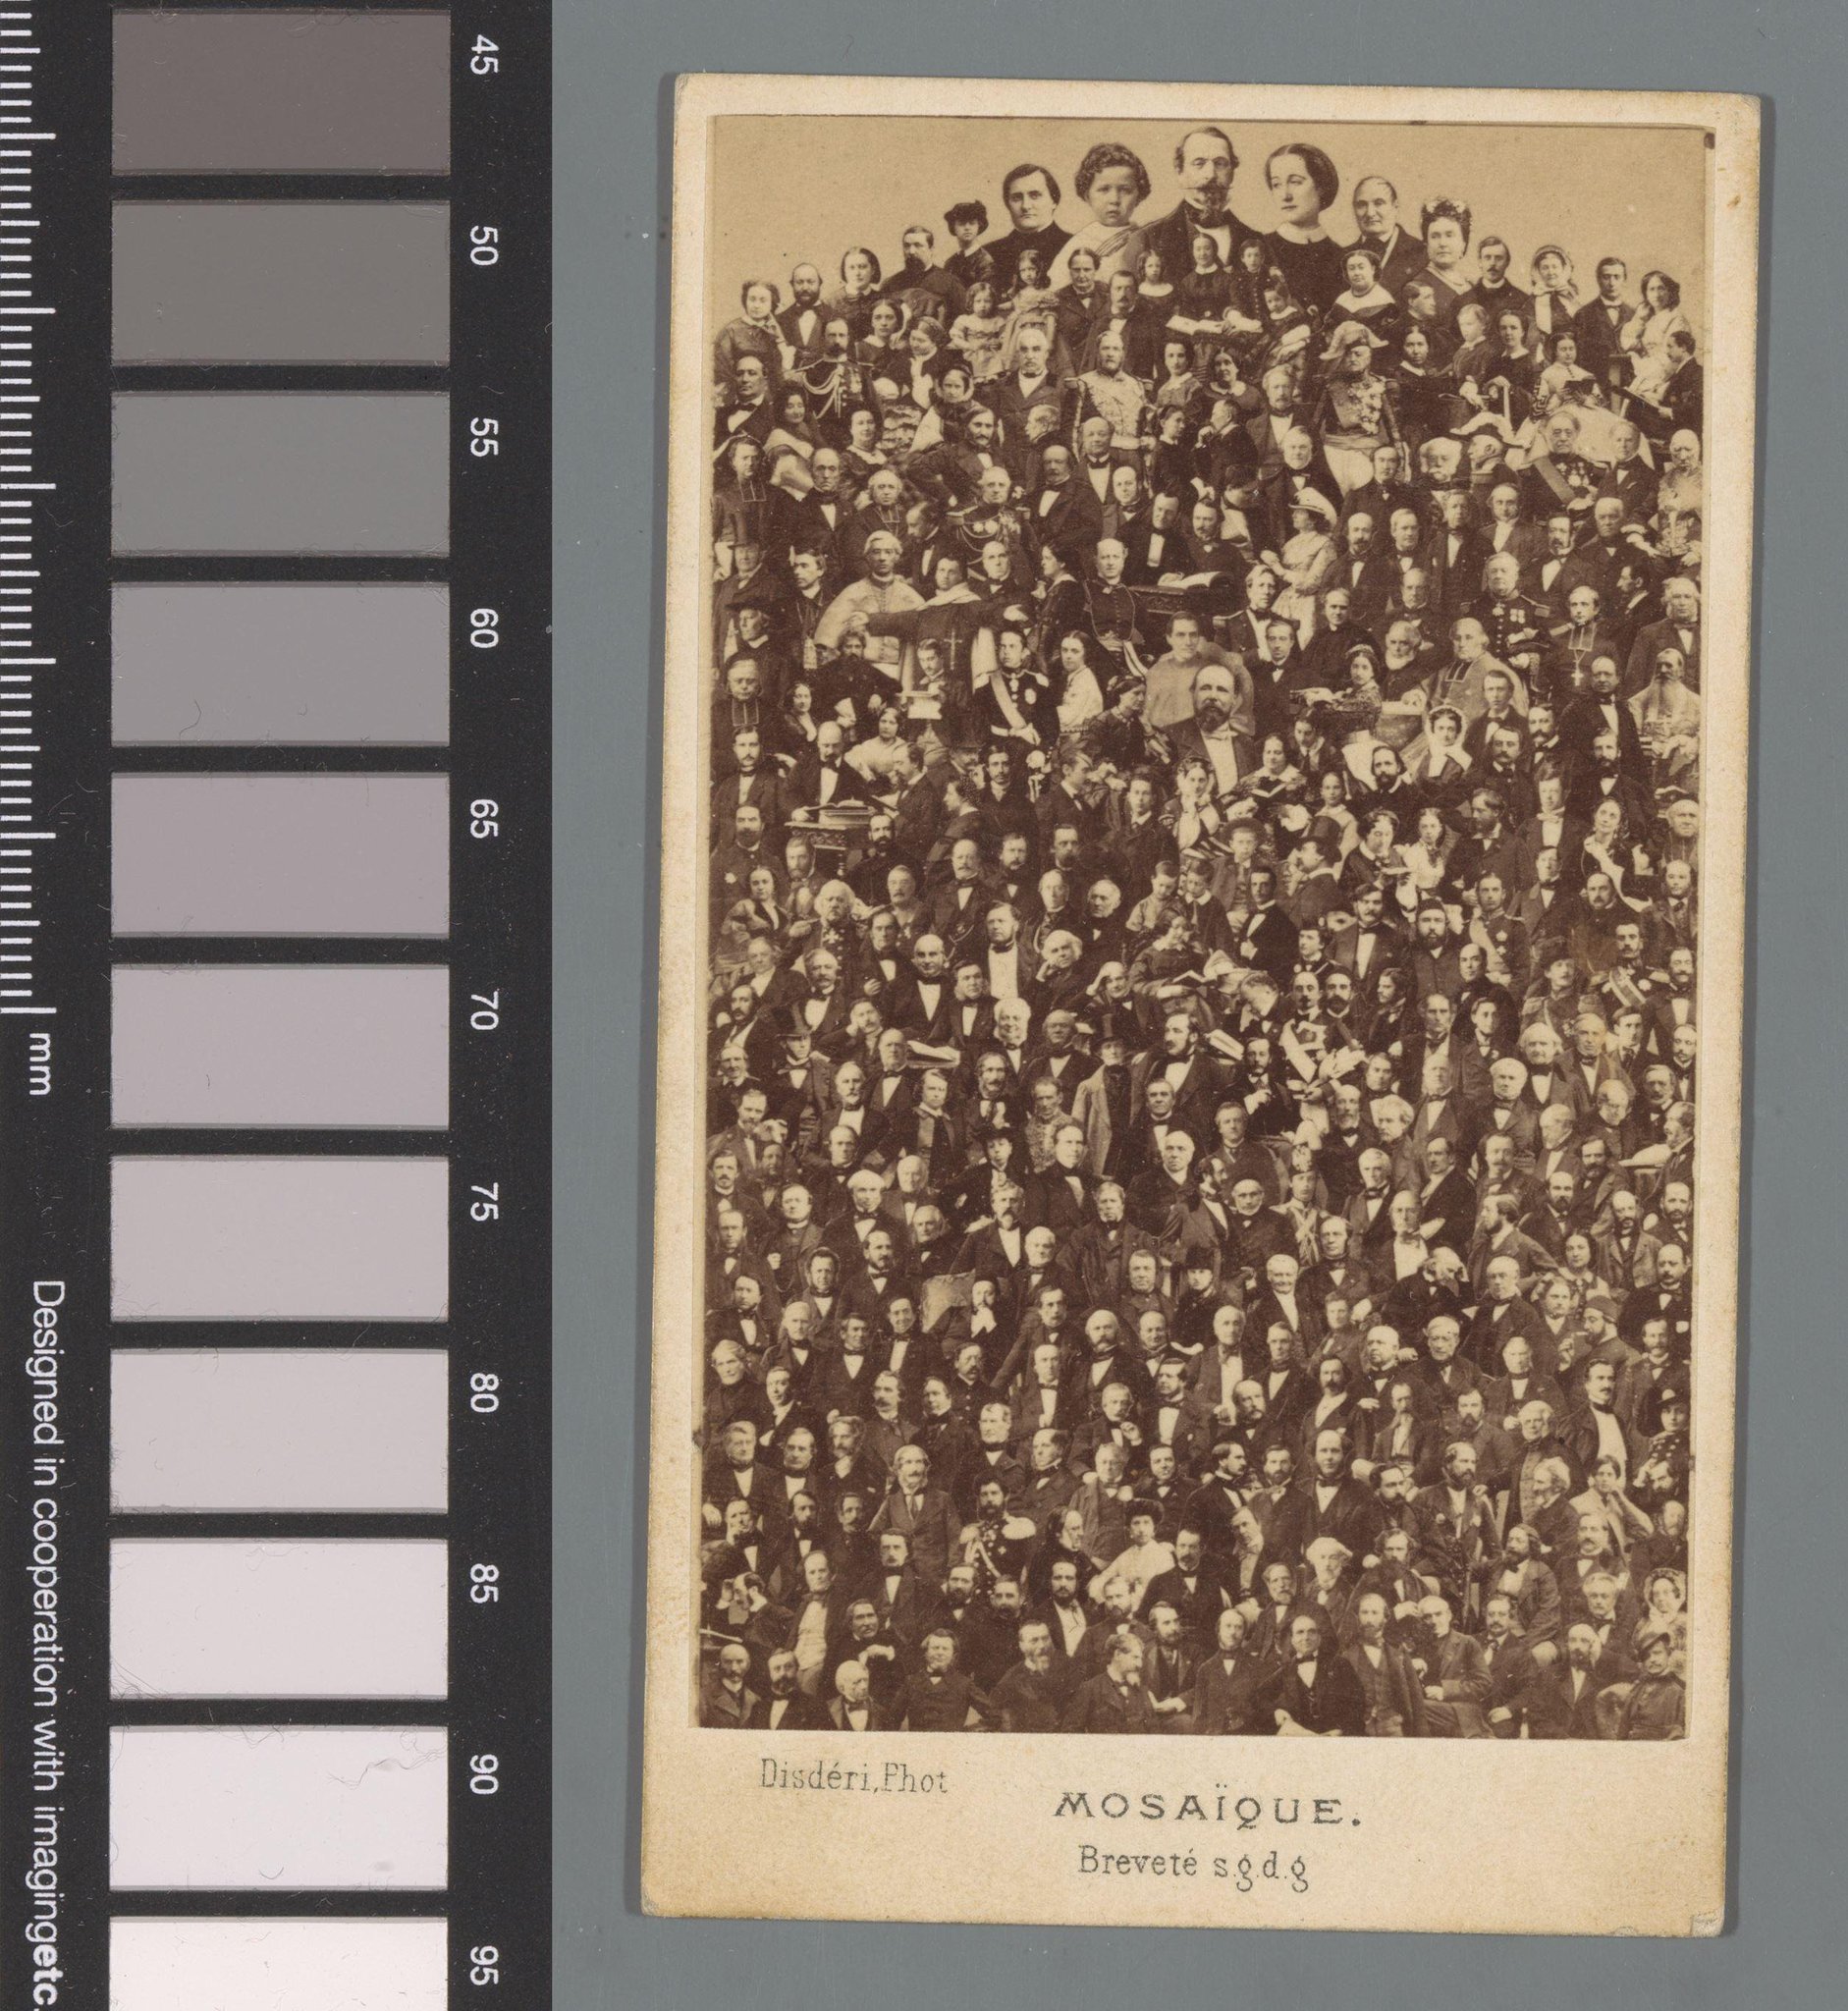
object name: photograph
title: Mosaïque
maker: andré-adolphe-eugène disdéri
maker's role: fotograaf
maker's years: 1819-1889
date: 1859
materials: paper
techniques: albumen print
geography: paris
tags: paris, napoleon iii (keizer der fransen), willem iii (koning der nederlanden), willem (prins der nederlanden), historical persons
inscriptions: inscription: ‘Disdéri, Phot. / MOSAÏQUE. / Breveté s.g.d.g.’, signature and address: ‘DISDÉRI / PHOTOGRAPHE DE S.M. L'EMPEREUR / 8, Boulevart [sic] des Italiens / PARIS’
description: Collage van portretten van bekende personen, onder wie koning Willem III, keizer Napoléon III en kroonprins Willem. Met bijbehorende naamlijst (RP-D-2013-8).